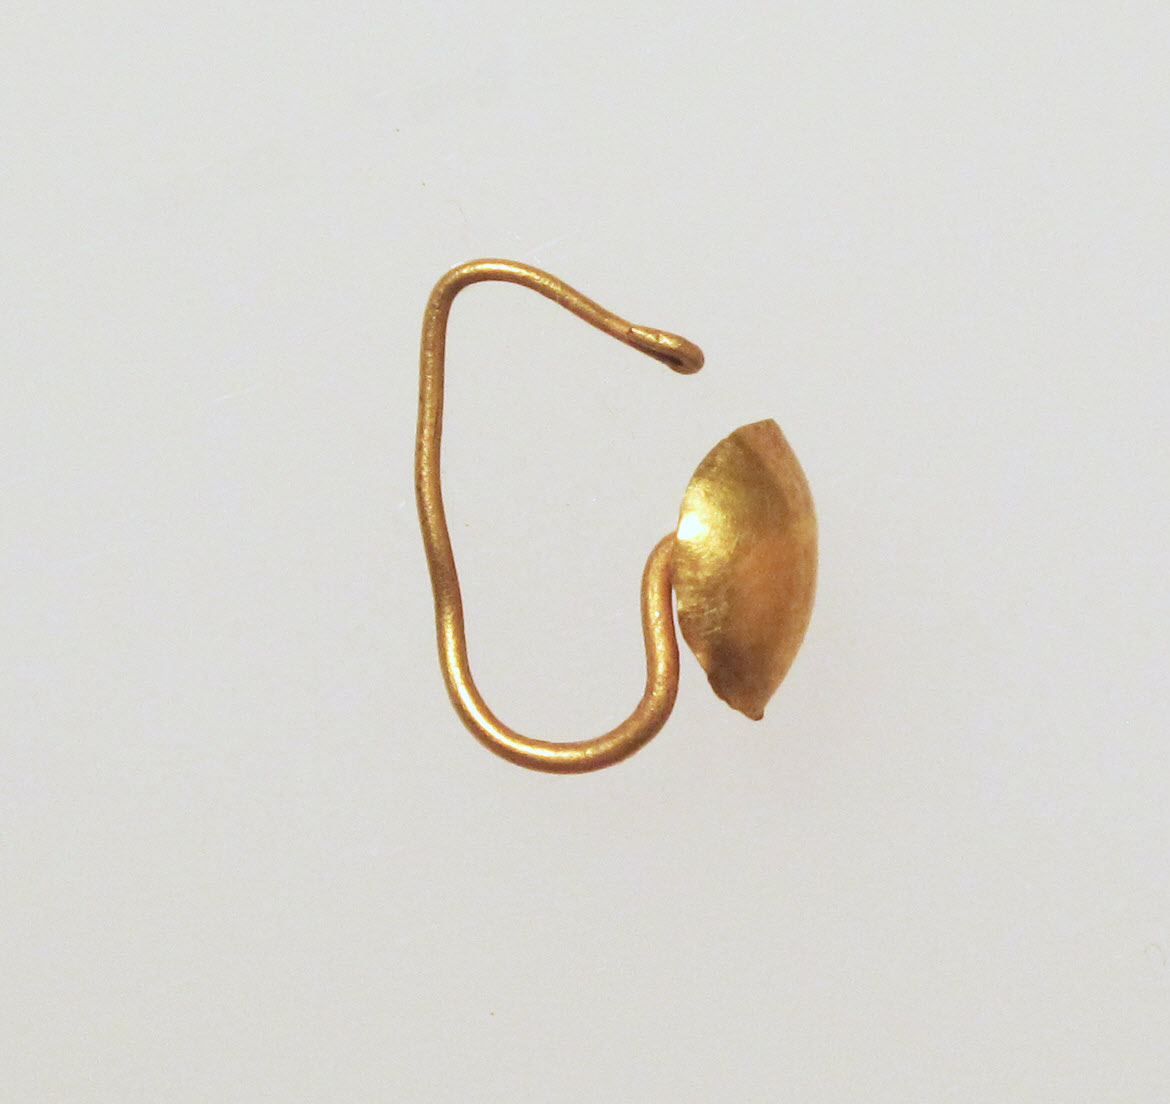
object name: earring with plain loop and disc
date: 7000 BCE-330 CE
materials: gold